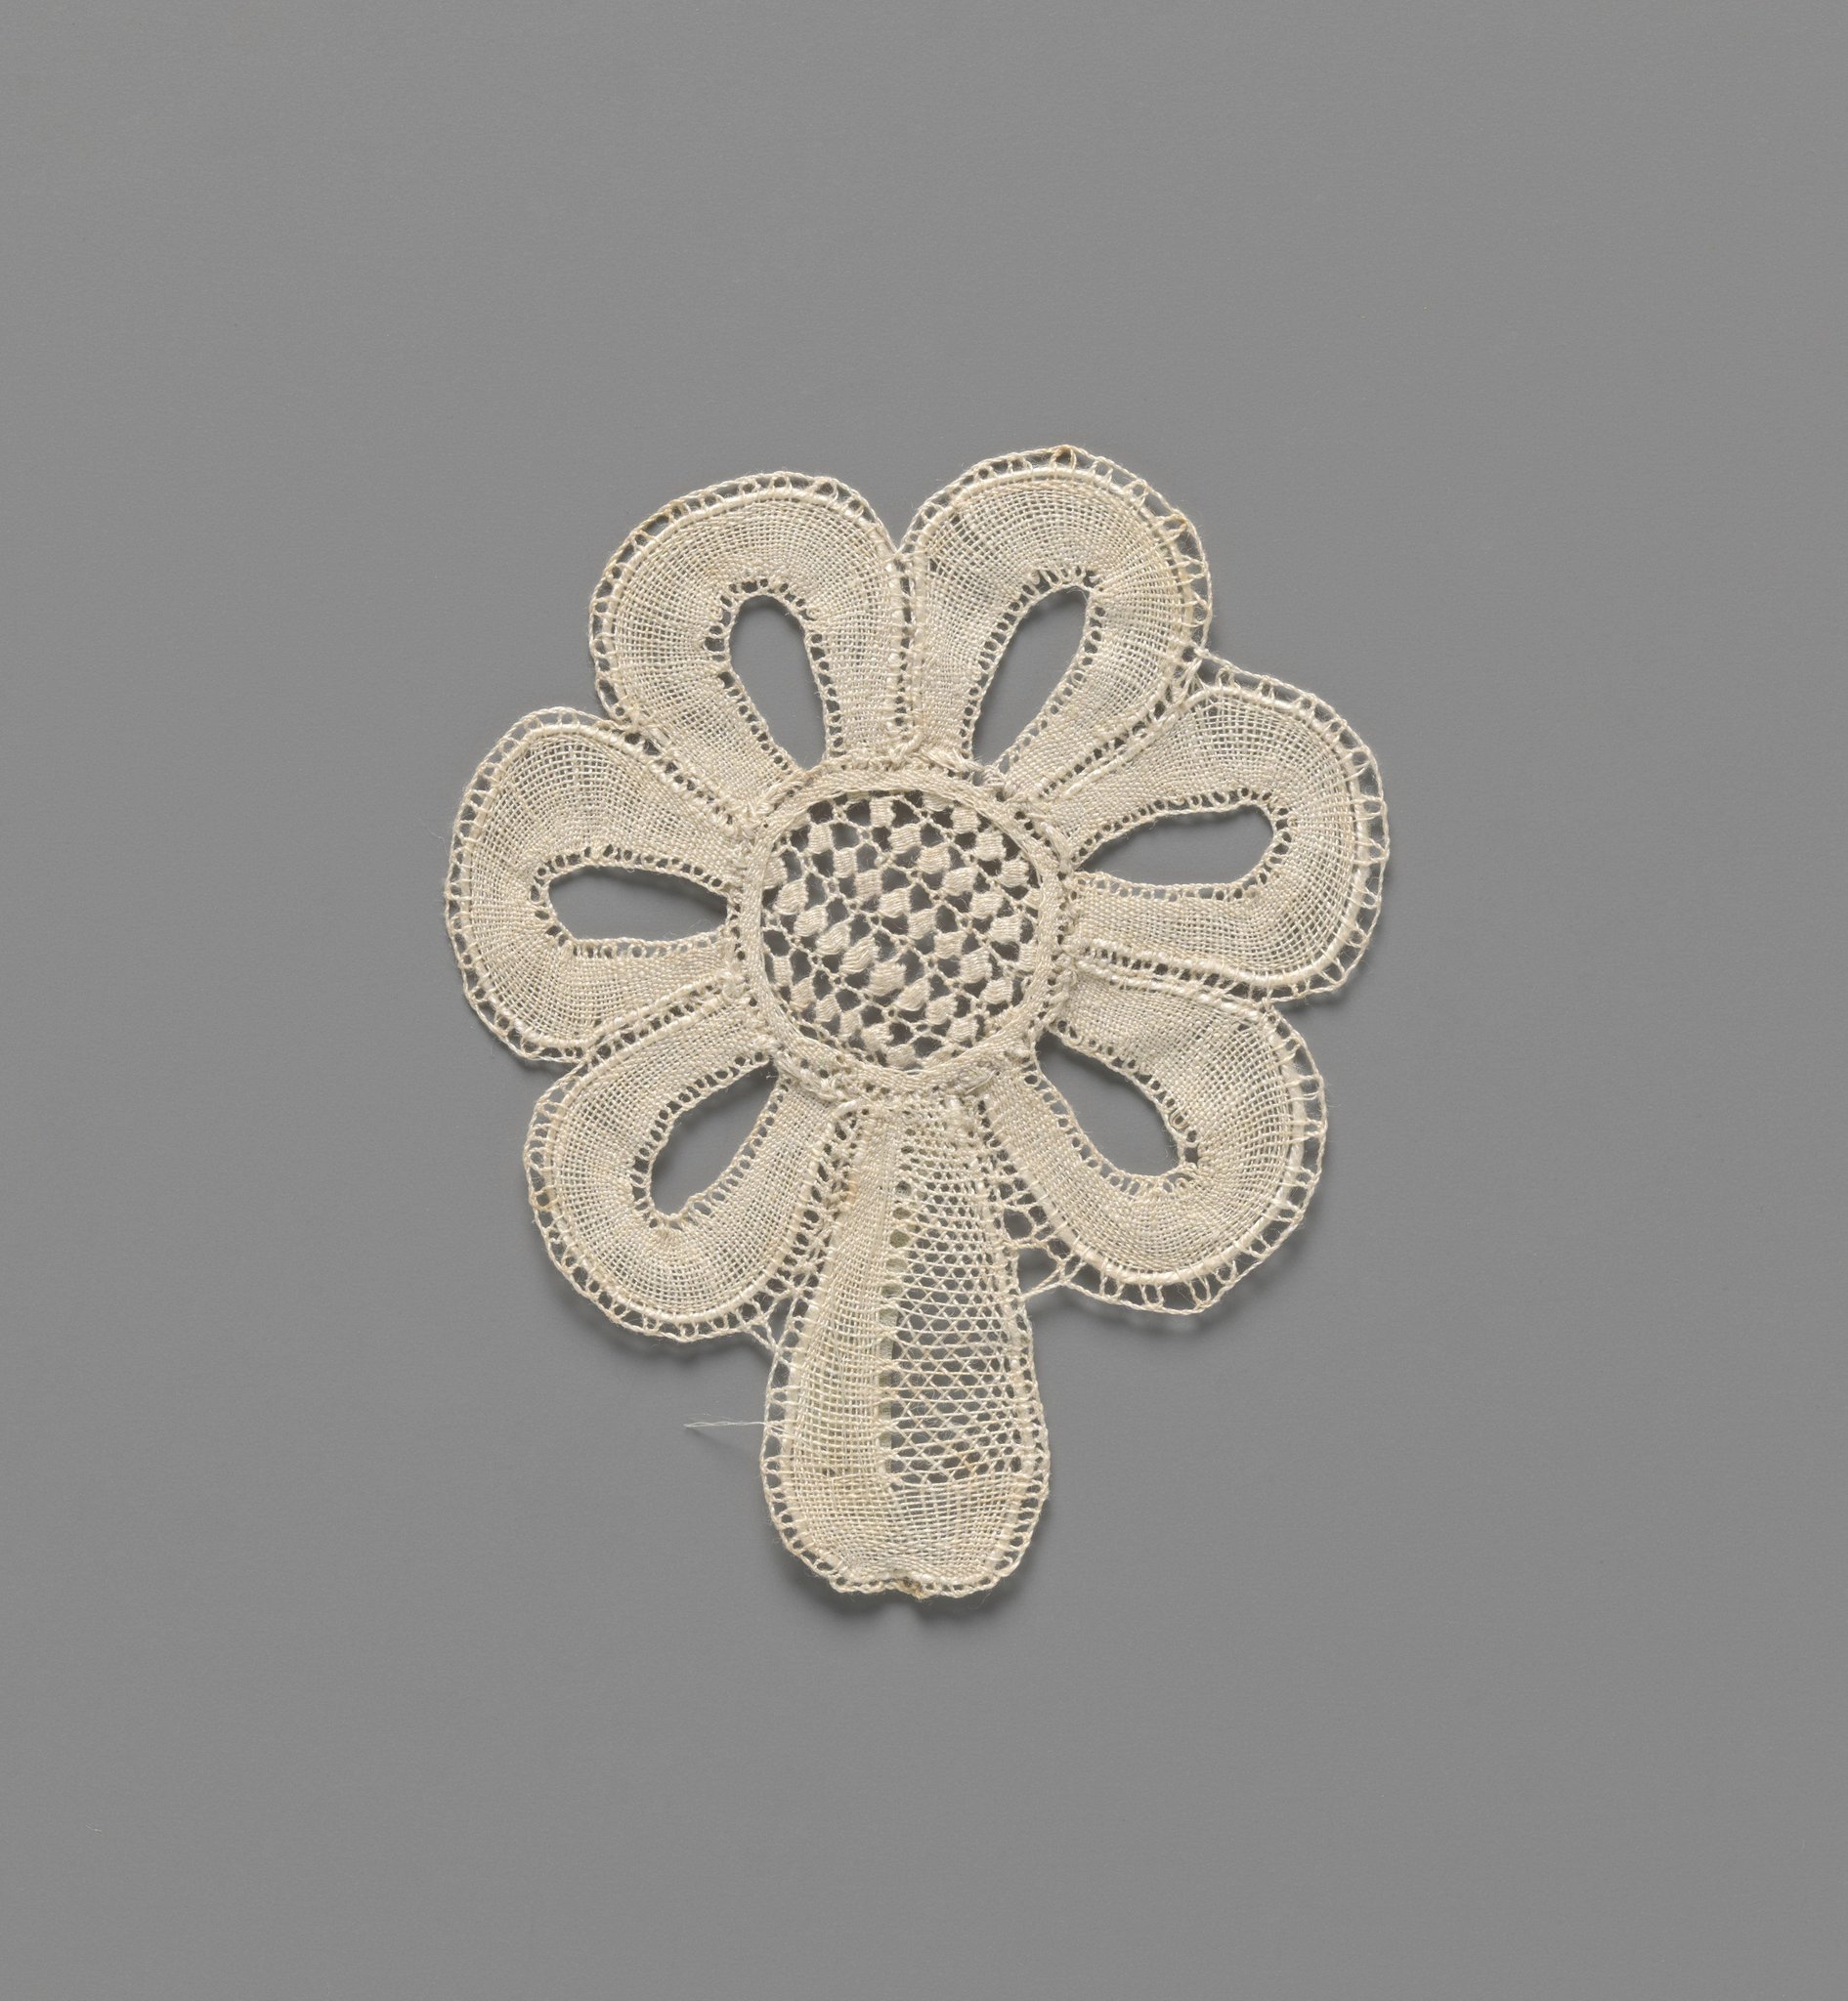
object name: motif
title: Motief van kloskant in de vorm van een zesbladige roos op een korte steel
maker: sophia gerardine cenijn-smit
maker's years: 1876-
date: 1914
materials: cotton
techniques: lace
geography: amsterdam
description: Motief in de vorm van een zesbladige roos op een korte steel gemaakt van kloskant: duchesse-kant. De hoefijzervormige contouren van de opengewerkte bloembladeren zijn gemaakt in linnenslag met opengewerkte randjes en met een dikkere en glimmende contourdraad langs de buitenranden. Het bloemhart heeft een rastervulling (siergrond) met blokjes gemaakt in vormslag. De korte stompe steel is deels gemaakt in linnenslag zoals de bloemblaadjes en deels in netslag.